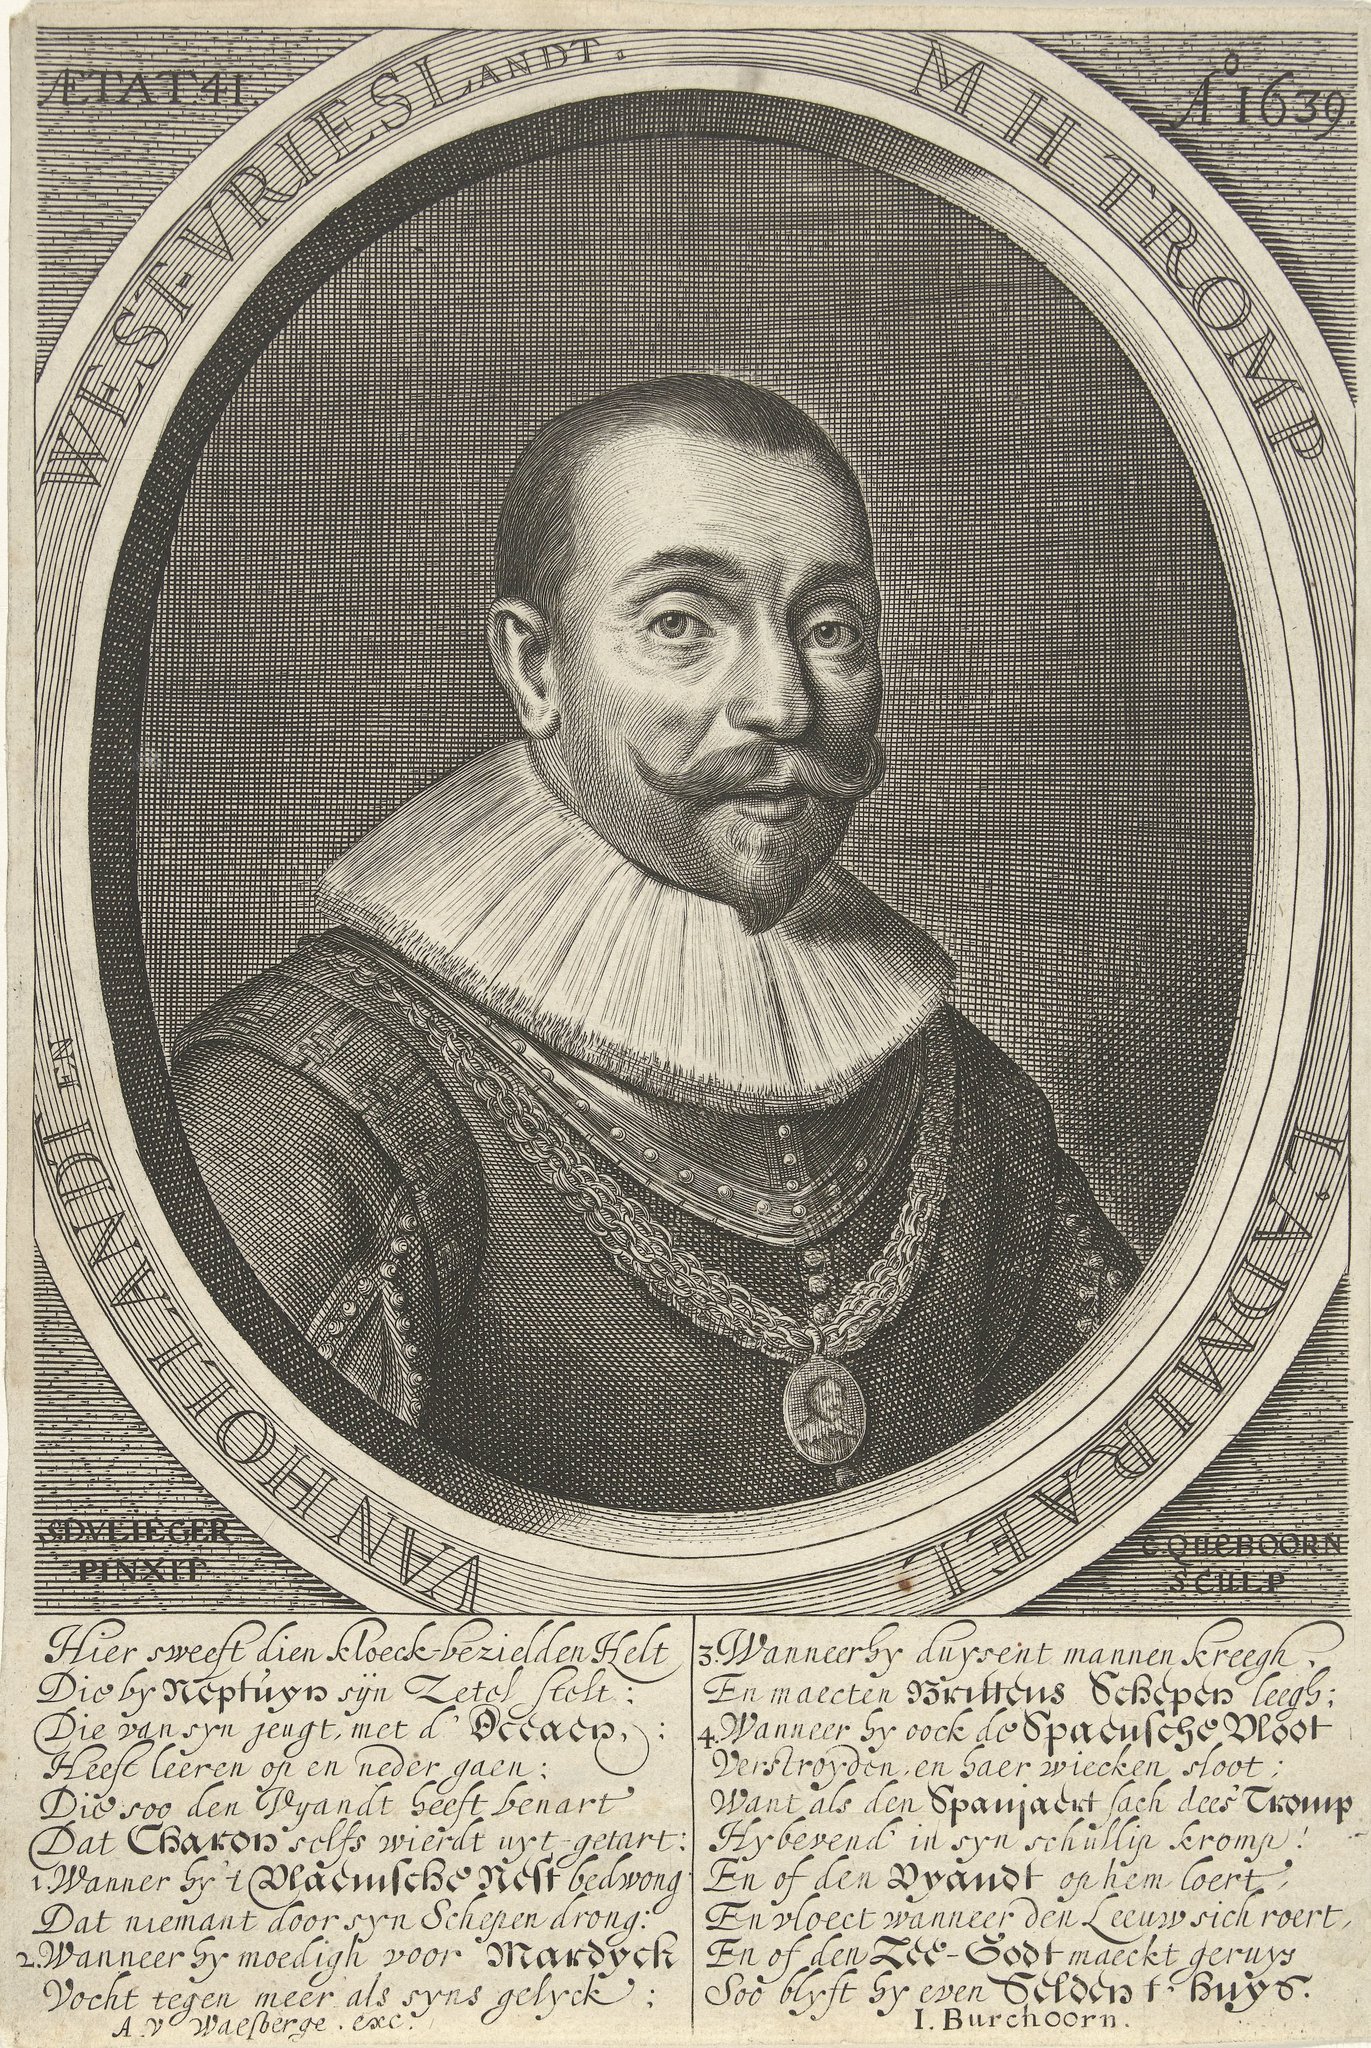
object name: print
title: Portret van Maarten Tromp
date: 1639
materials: paper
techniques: engraving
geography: amsterdam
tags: brielle, maarten harpertszoon tromp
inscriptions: collector's mark: Lugt 2228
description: Portret van admiraal Maarten Harpertszoon Tromp op 41-jarige leeftijd met om zijn hals een medaillon. In de marge een heldendicht op Tromp.